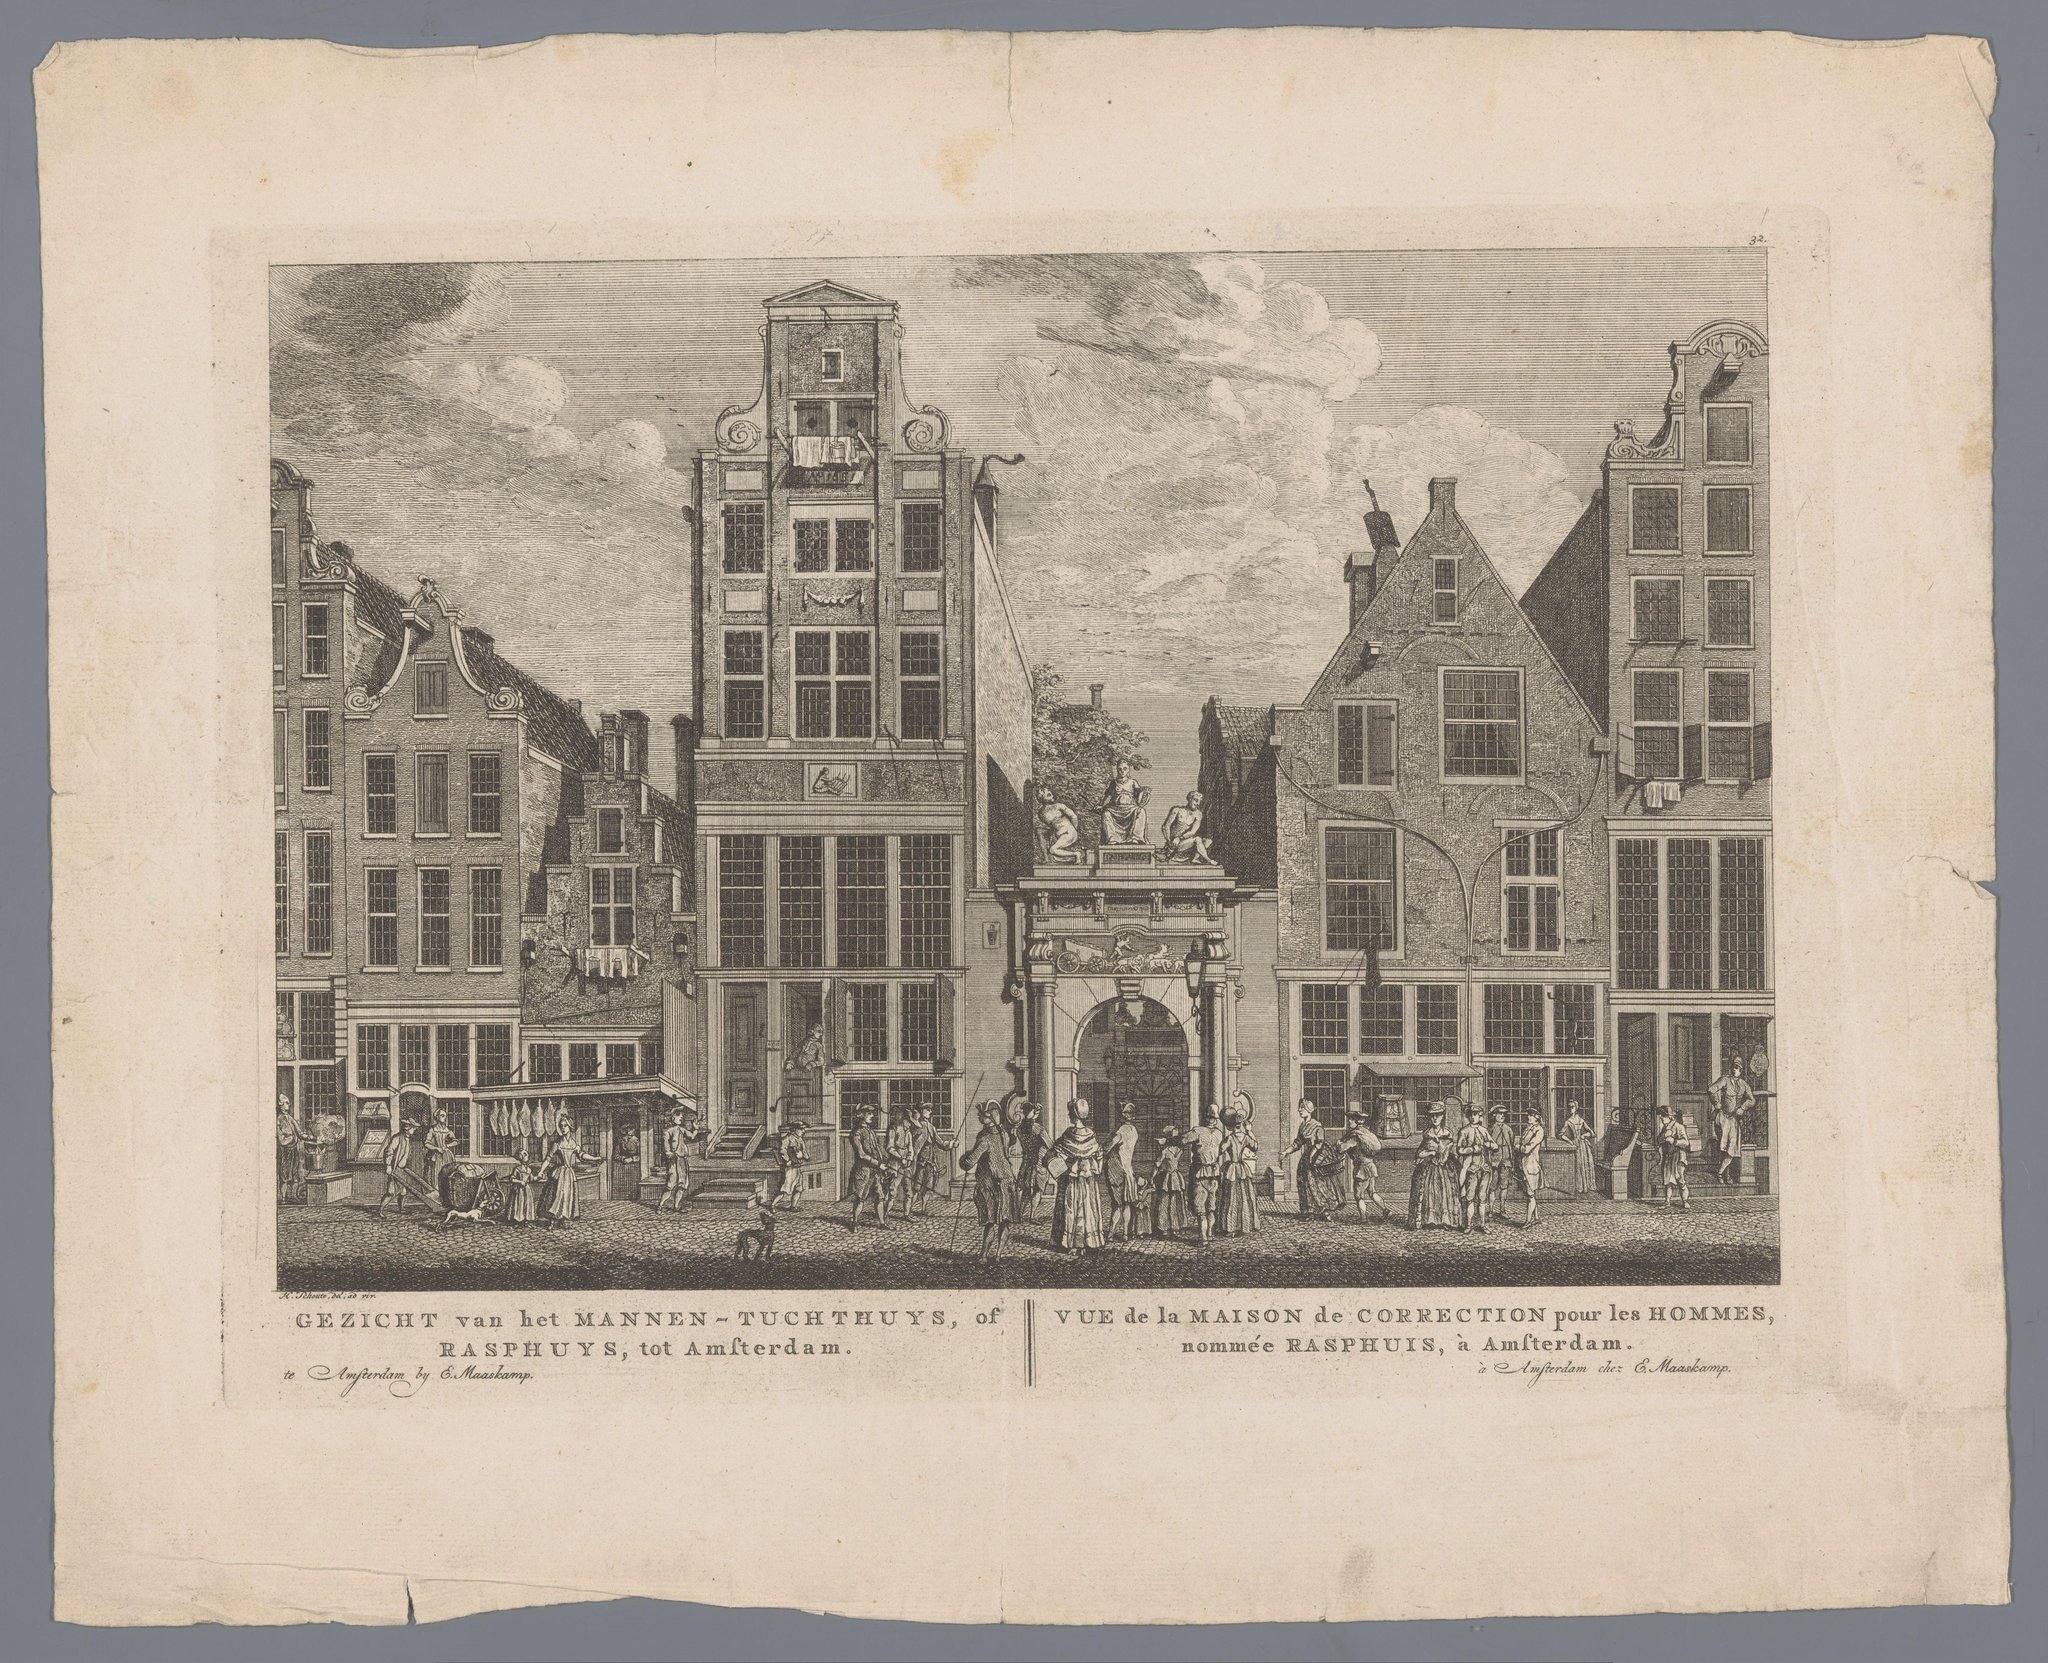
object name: print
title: Atlas van Fouquet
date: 1805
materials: paper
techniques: etching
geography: amsterdam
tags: prison, jail, workhouse, penal camp, penitentiary, chain gang, street (+ city(-scape) with figures, staffage)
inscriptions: collector's mark: Lugt 2228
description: Prent uit: Nieuwe atlas, van de voornaamste gebouwen en gezigten der stad Amsterdam. Met derzelver beknopte beschryvingen. Amsterdam: Evert Maaskamp, 1805. De prent werd eerder uitgegeven door Pierre Fouquet als onderdeel van de zogenaamde Atlas van Fouquet: stadsgezichten van Amsterdam naar tekeningen van verschillende kunstenaars. Deze prenten werden aanvankelijk (vanaf ca. 1760) los verkocht en later (1783) samengebonden gepubliceerd.